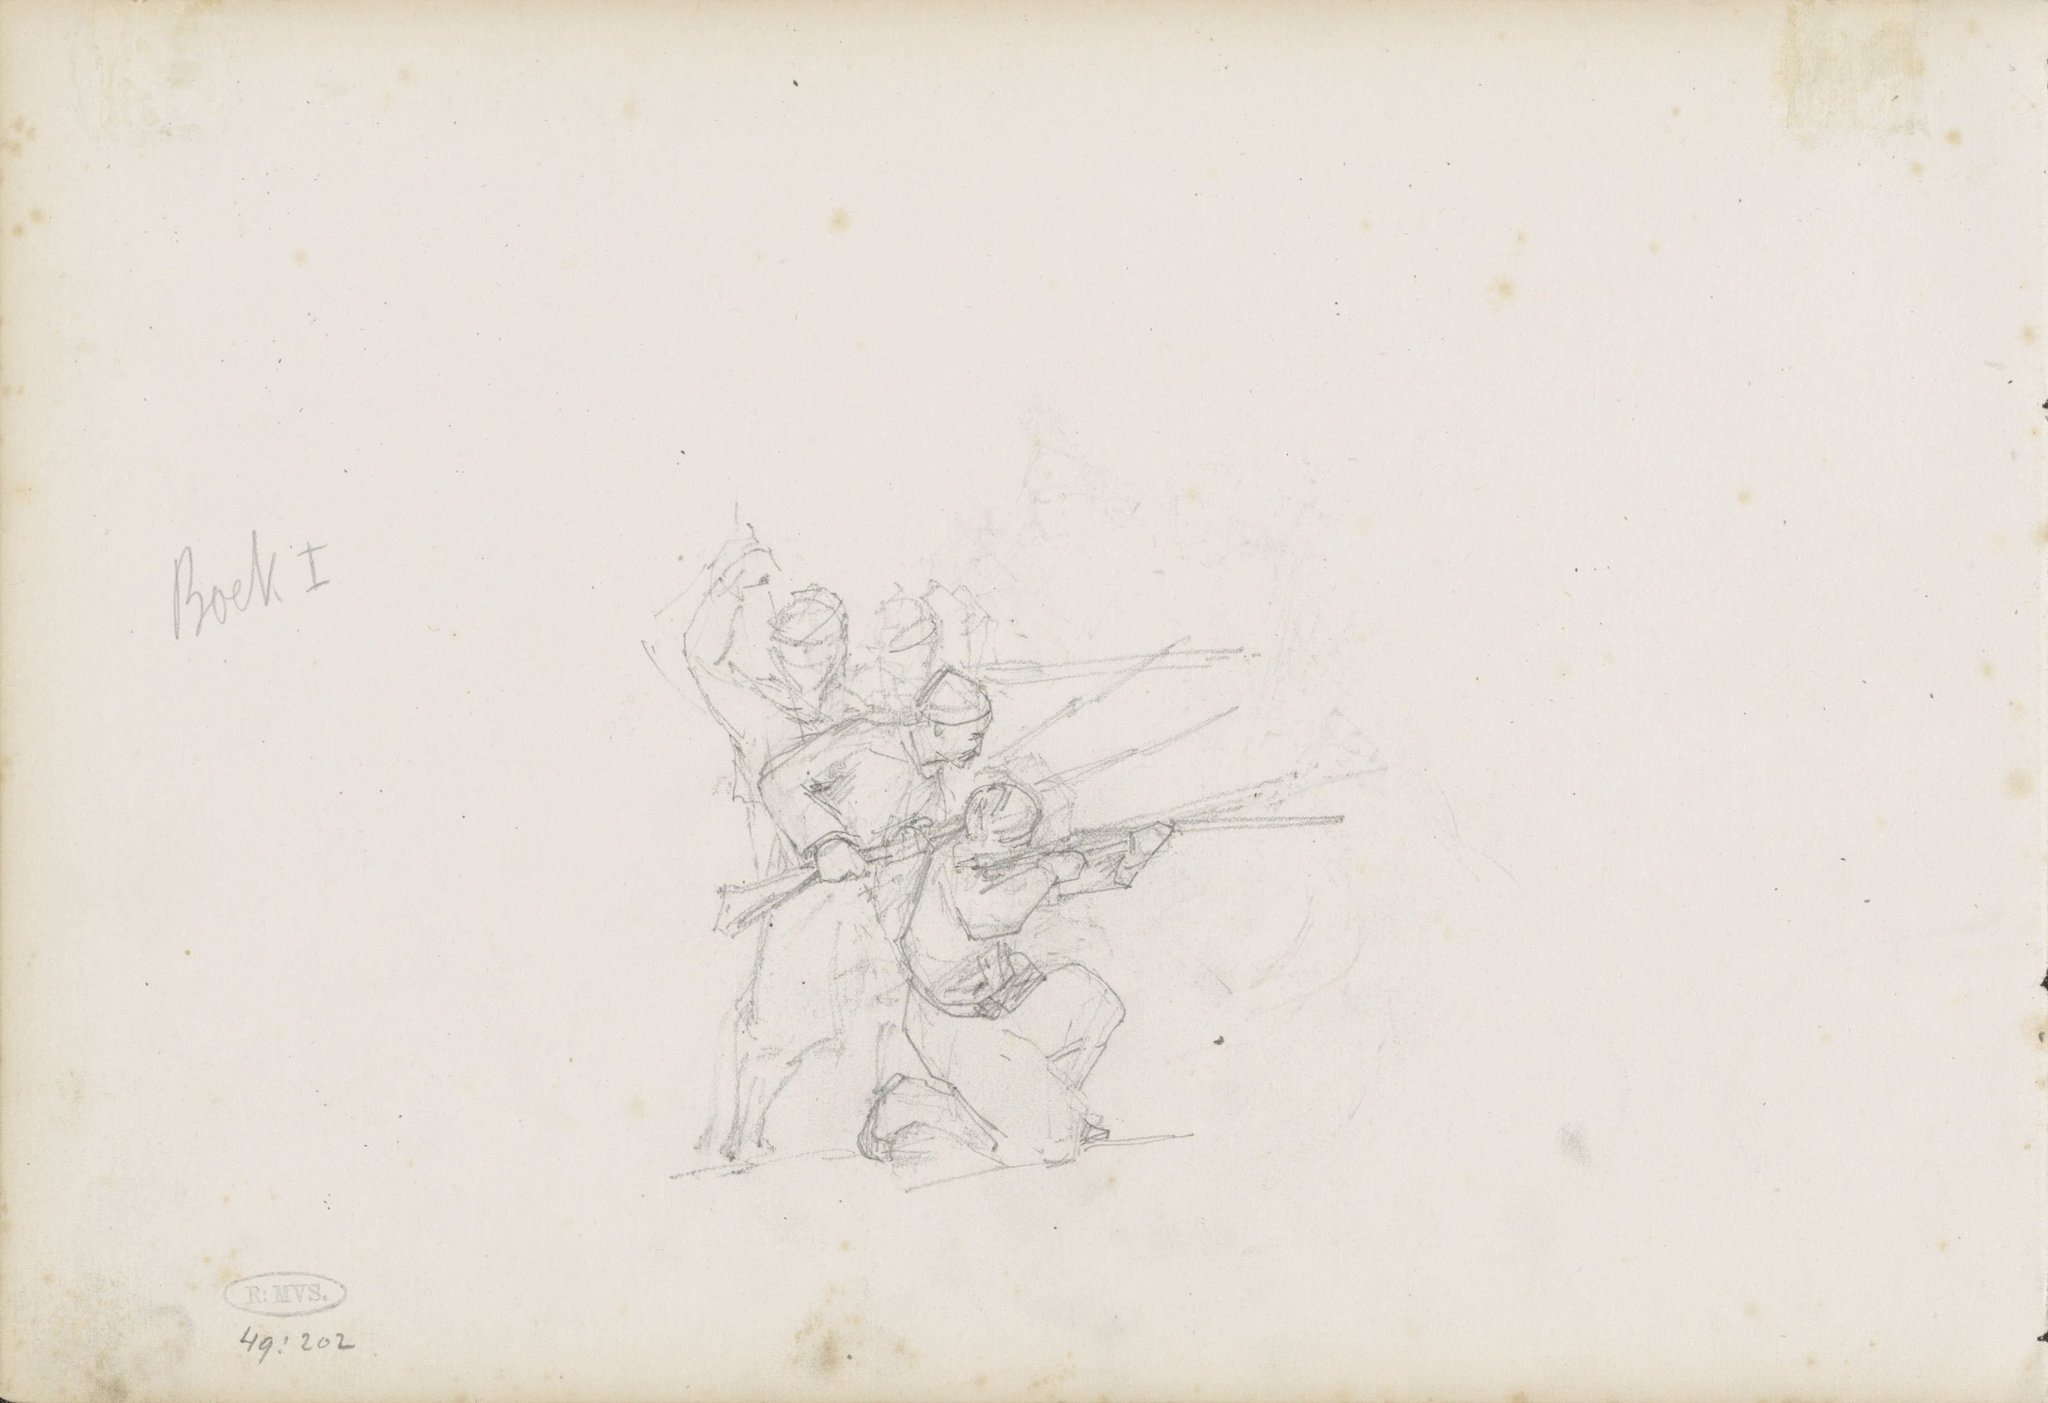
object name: drawing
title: Soldaten met getrokken geweren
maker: george hendrik breitner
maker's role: draughtsman, painter, print maker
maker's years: 1857-1923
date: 1872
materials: paper, pencil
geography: rotterdam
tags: firearms: rifle, private soldier (+ during the battle)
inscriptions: collector's mark: Lugt 2228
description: Deze tekening heeft oorspronkelijk als blad 15 deel uitgemaakt van een schetsboek. Zie voor dit schetsboek het gerelateerd object.